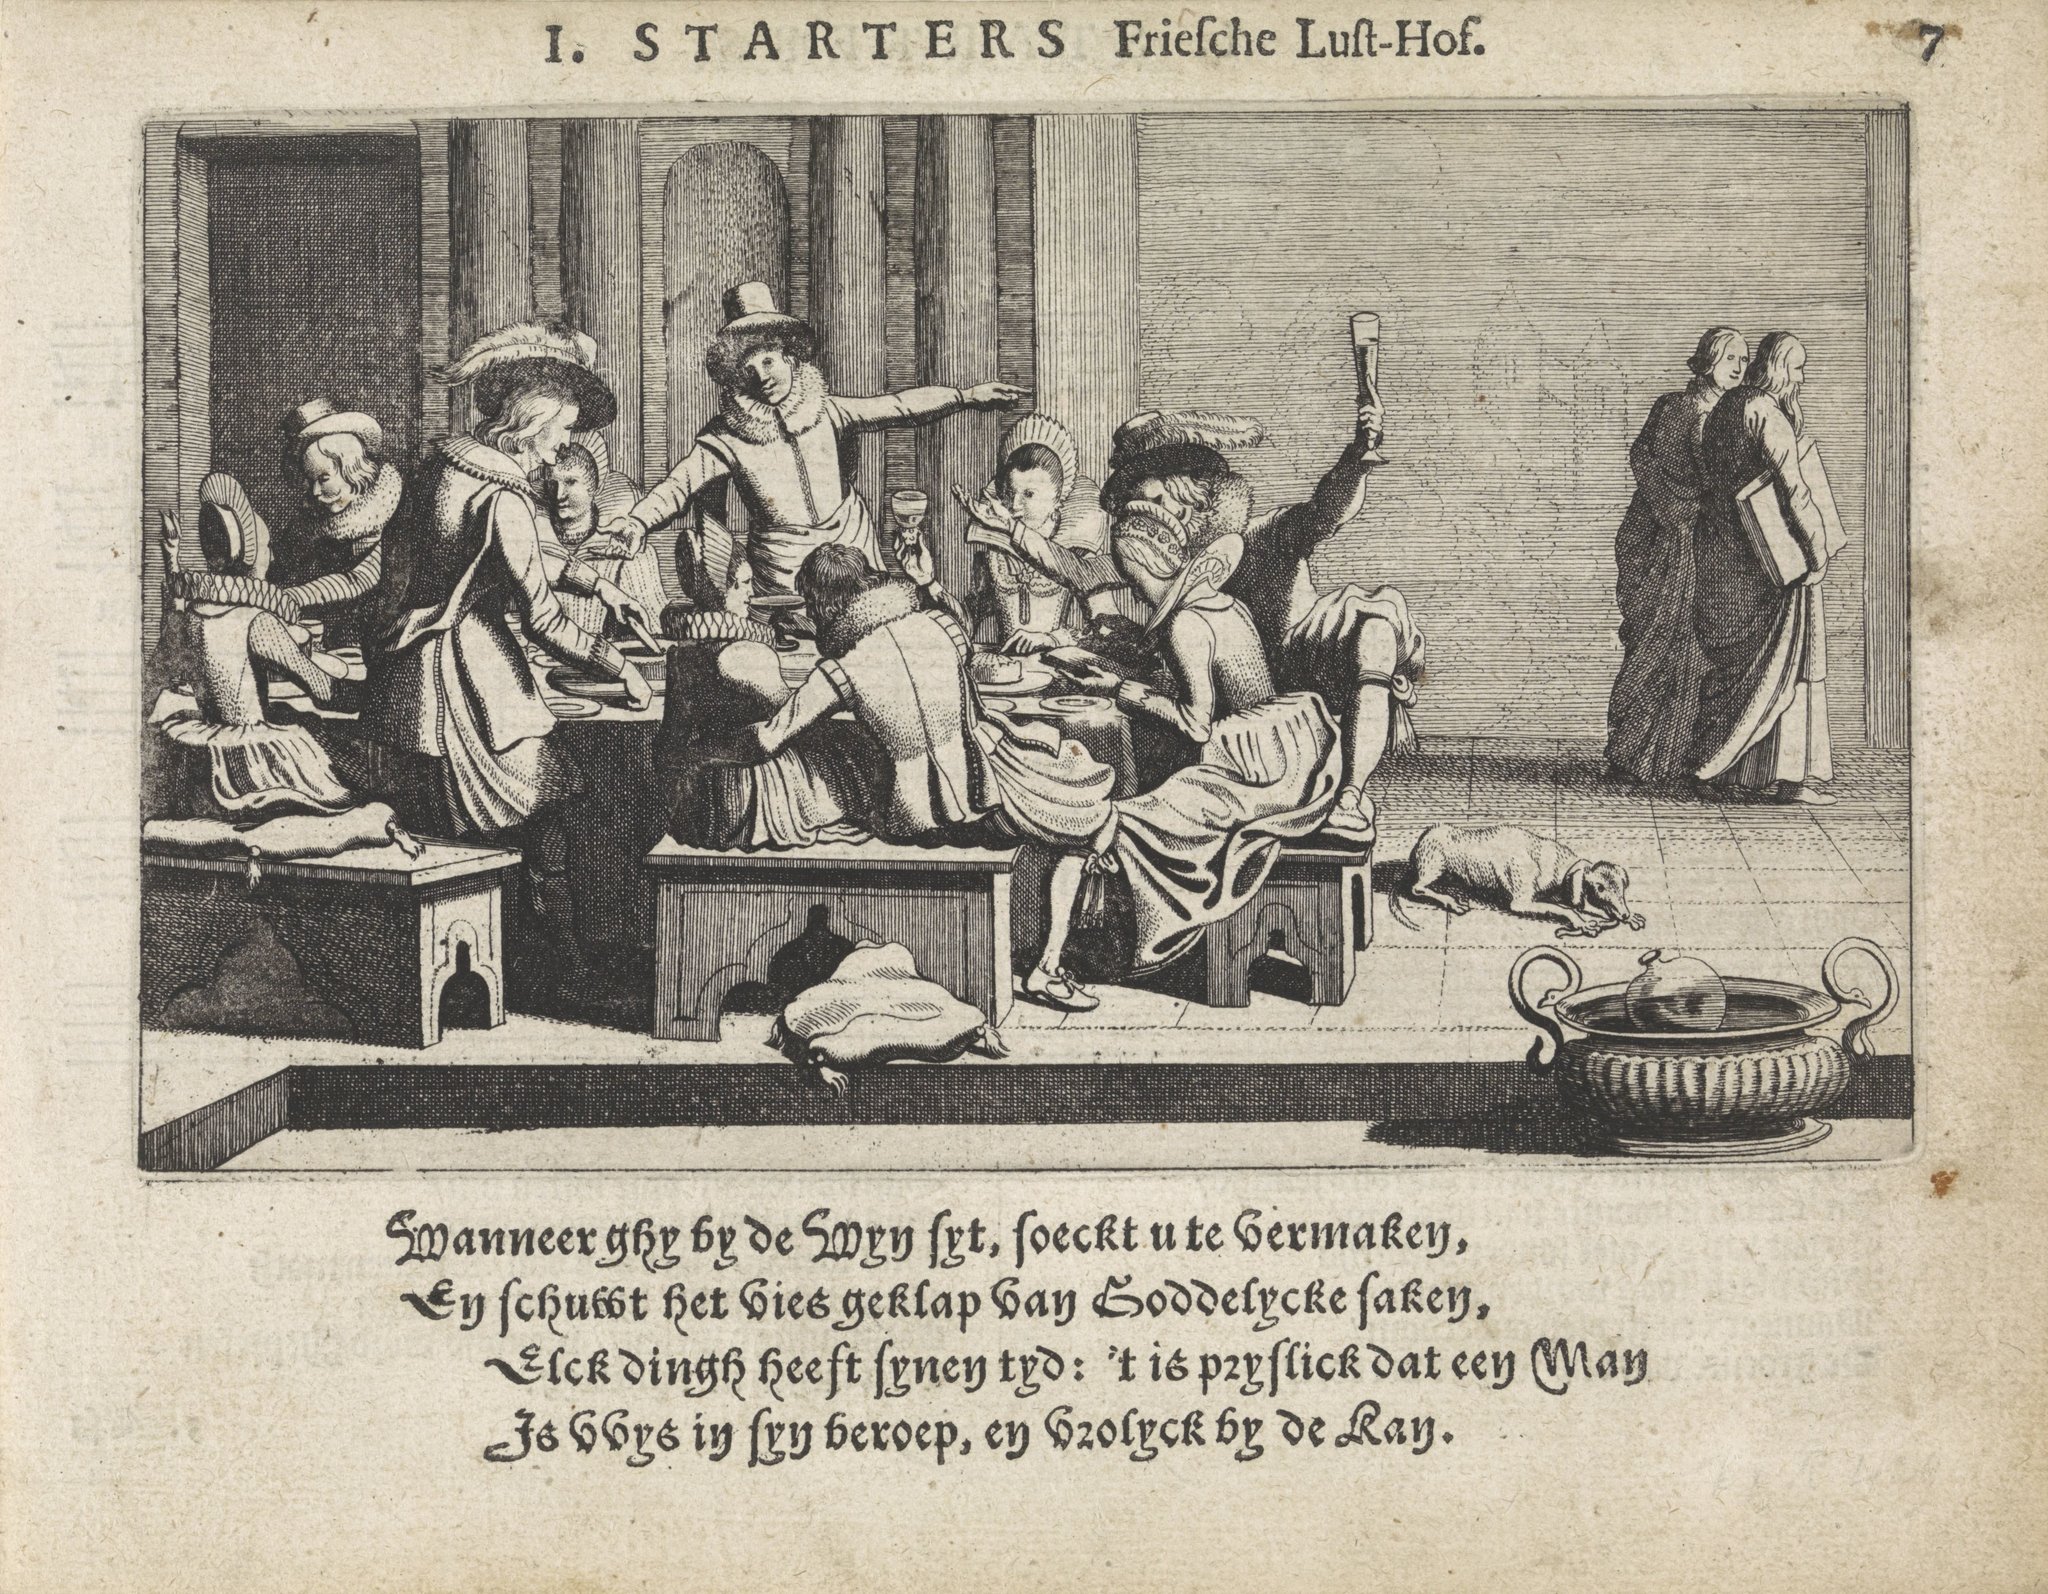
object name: print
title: Interieur met vrolijk gezelschap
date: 1621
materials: paper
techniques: etching, letterpress printing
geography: amsterdam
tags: banquet of elegant company, drinking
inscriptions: collector's mark: Lugt 964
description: Boekillustratie in: Starter, Jan Jansz. Friesche lust-hof, beplant met verscheyde stichtelyke minne-liedekens, gedichten, ende boertige kluchten. Amsterdam: Dirck Pietersz Voscuyl, 1621.